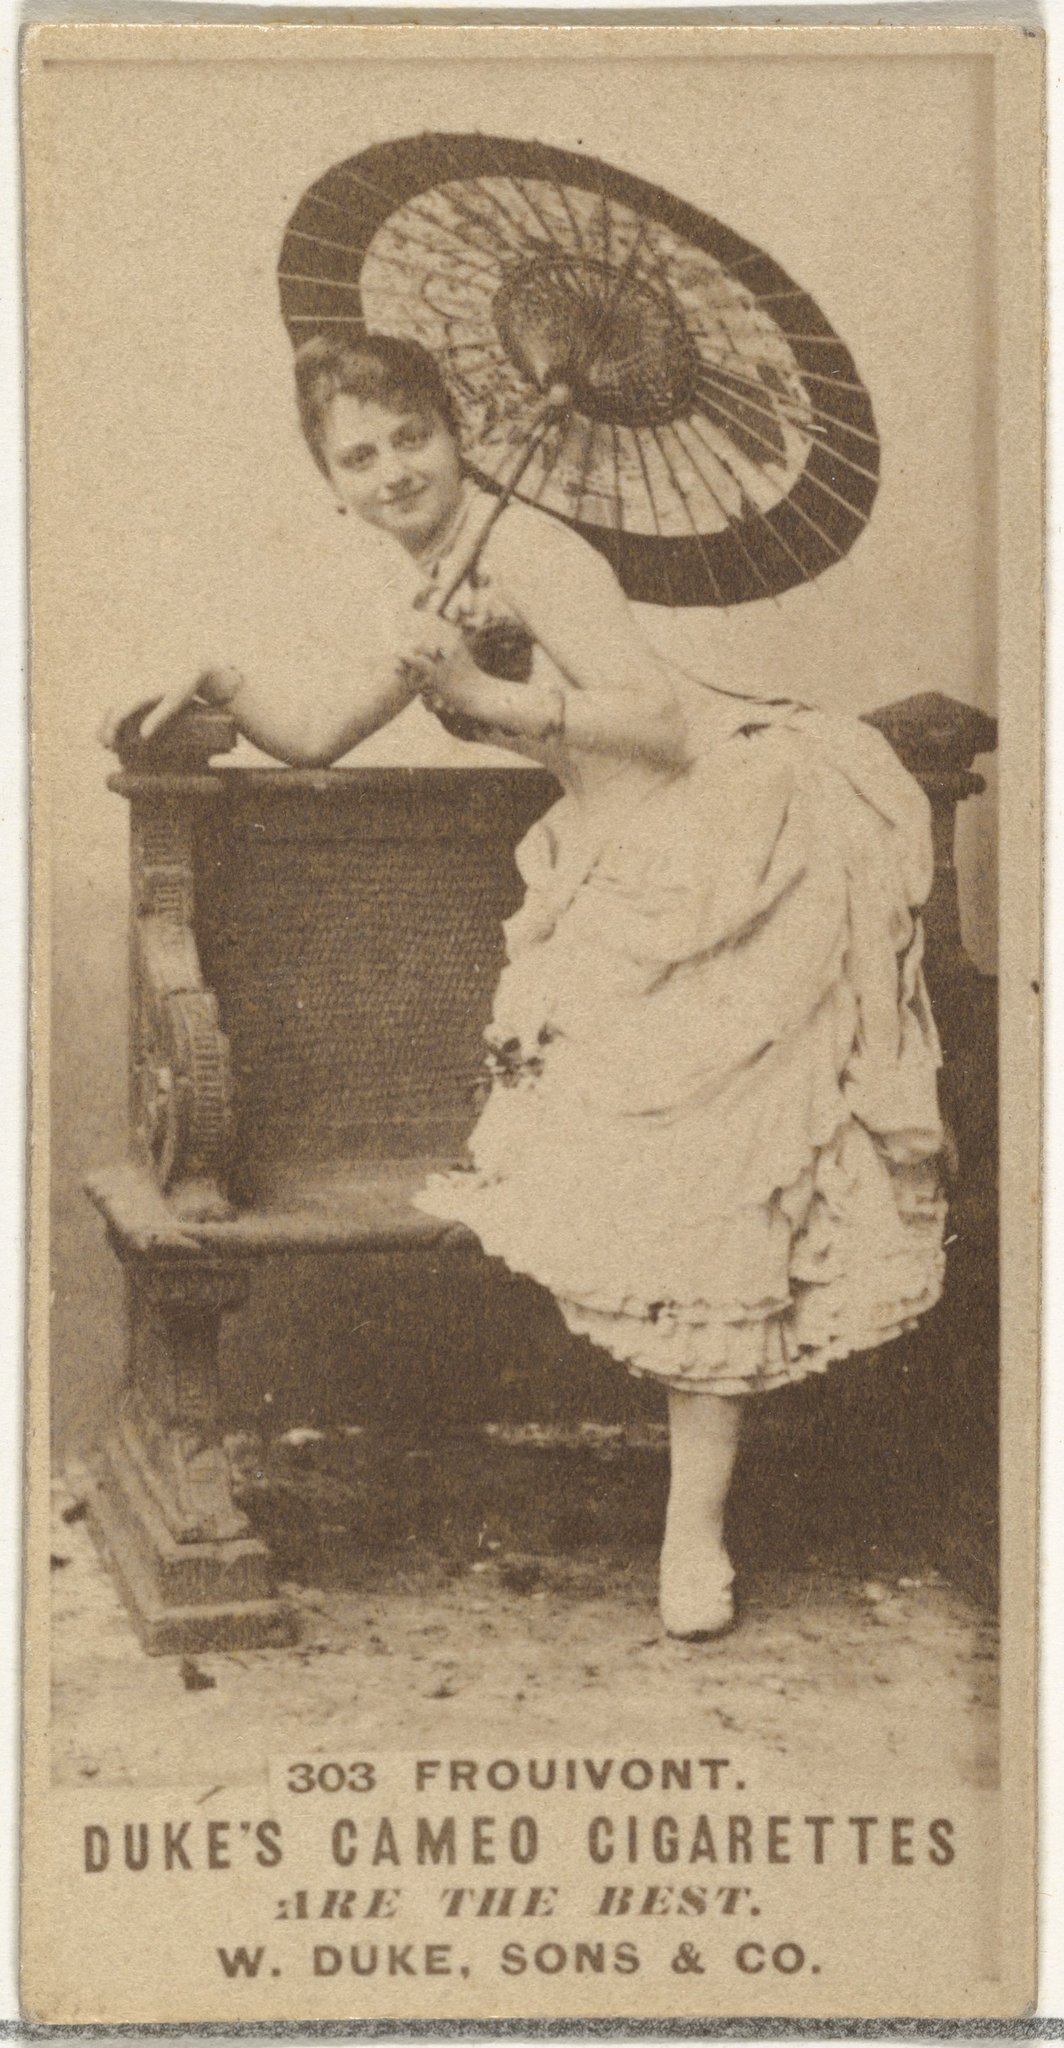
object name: photograph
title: Card Number 303, Frouivont, from the Actors and Actresses series (N145-5) issued by Duke Sons & Co. to promote Cameo Cigarettes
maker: w. duke, sons & co.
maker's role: publisher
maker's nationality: american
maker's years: 1870-1920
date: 1880-1889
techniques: albumen silver print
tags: portraits,women,actresses